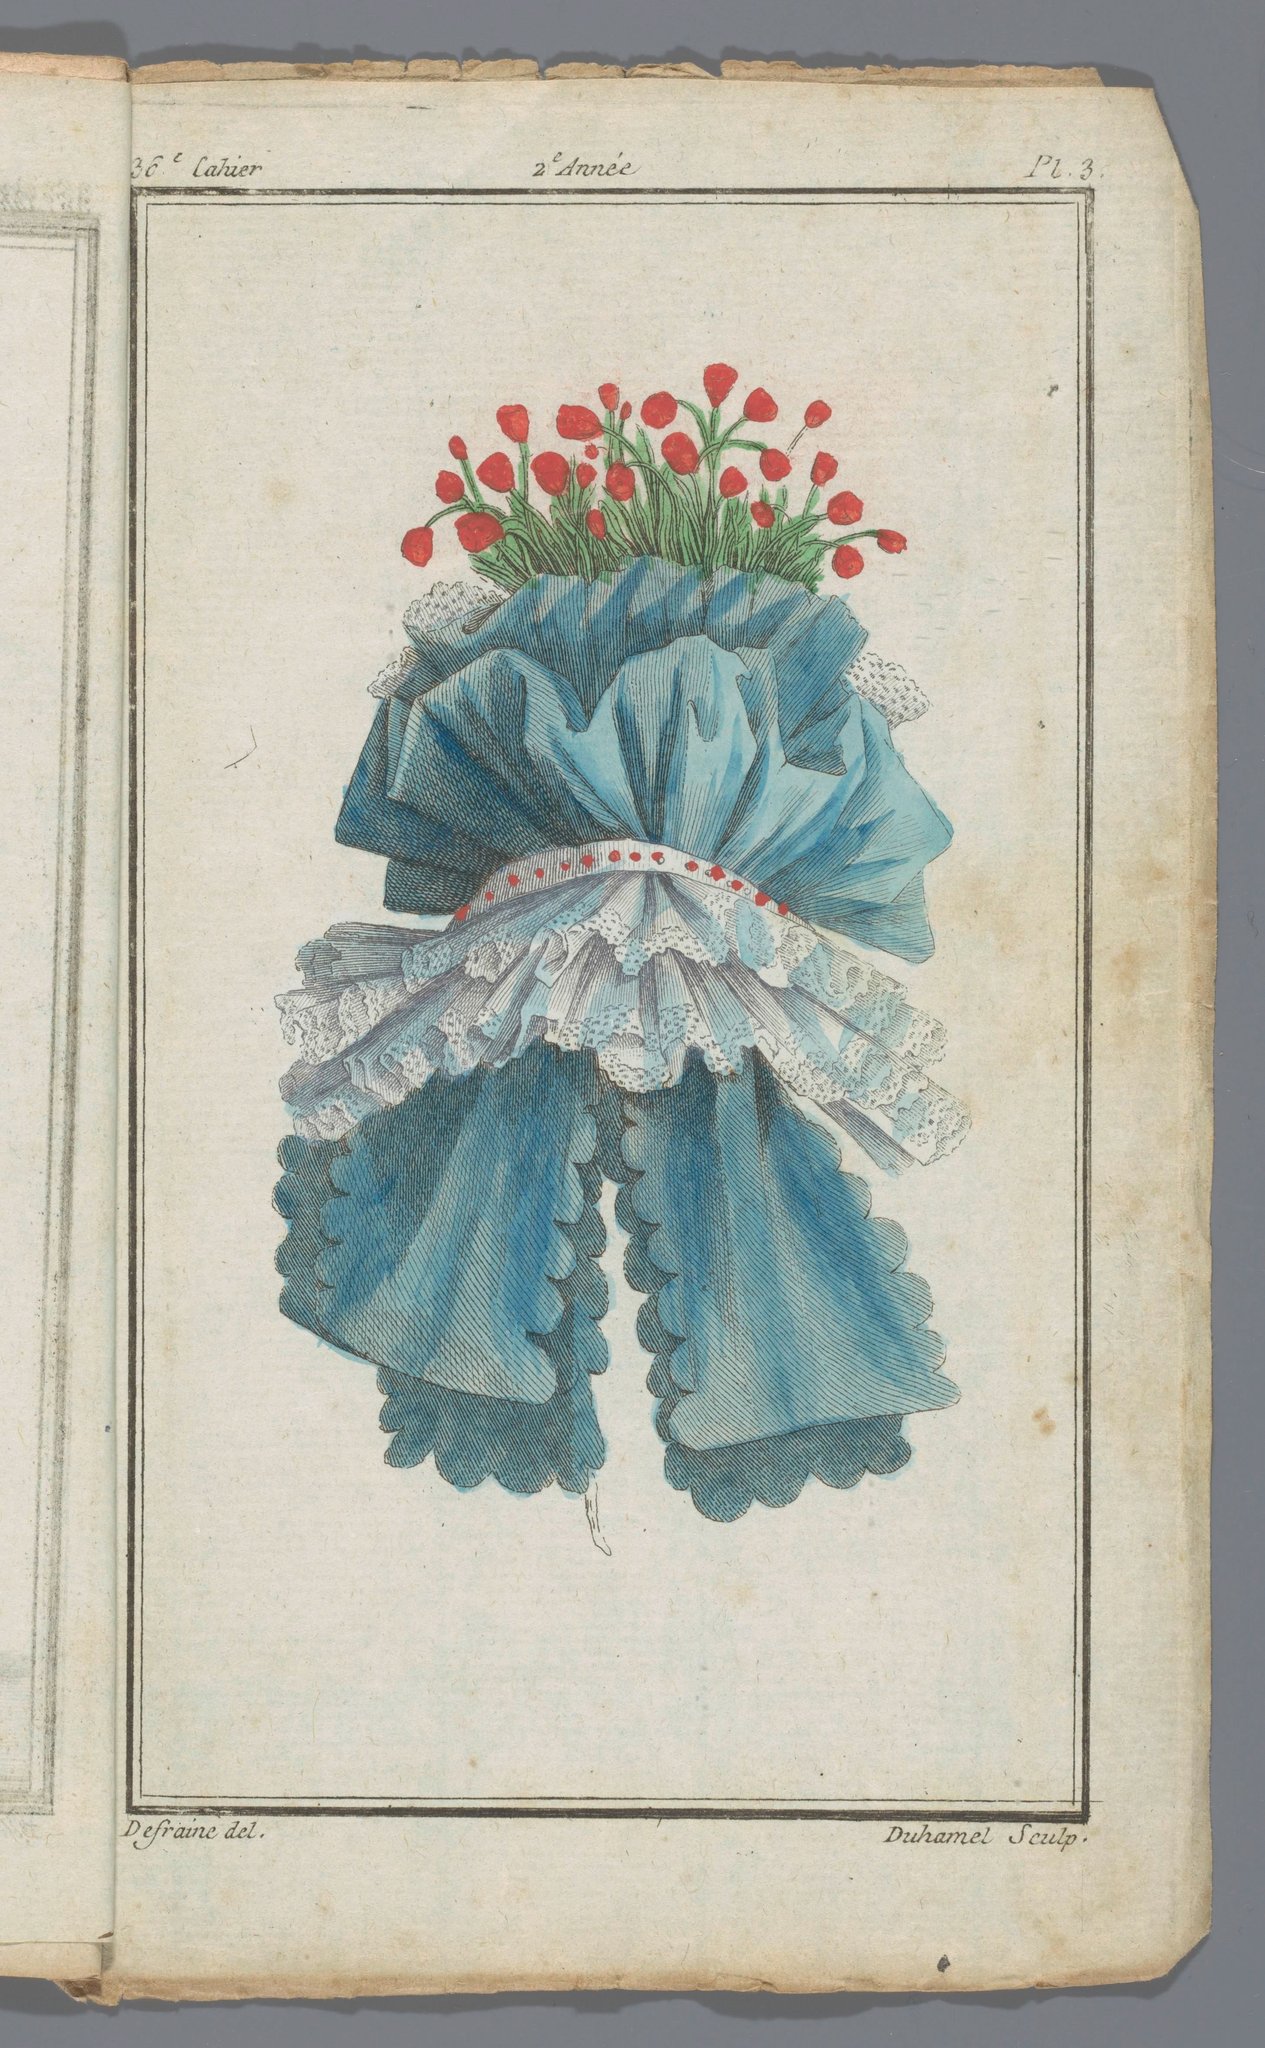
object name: fashion print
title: Magasin des Modes Nouvelles Françaises et Anglaises, 10 novembre 1787, 36e cahier, 2e année, Pl. 3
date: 1787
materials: paper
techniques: engraving, hand coloring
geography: paris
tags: head-gear: cap (+ women's clothes), fashion plates, flowers: poppy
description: Grote muts van blauwe crêpe met lange slippen en een toef klaprozen. De prent maakt deel uit van het 36e Cahier, 2e année, uit de serie Magasin des Modes Nouvelles Françaises et Anglaises. De serie bestaat uit 172 modeprenten, uitgegeven door Buisson, Parijs, 20 novembre 1786 - 21 décembre 1789.